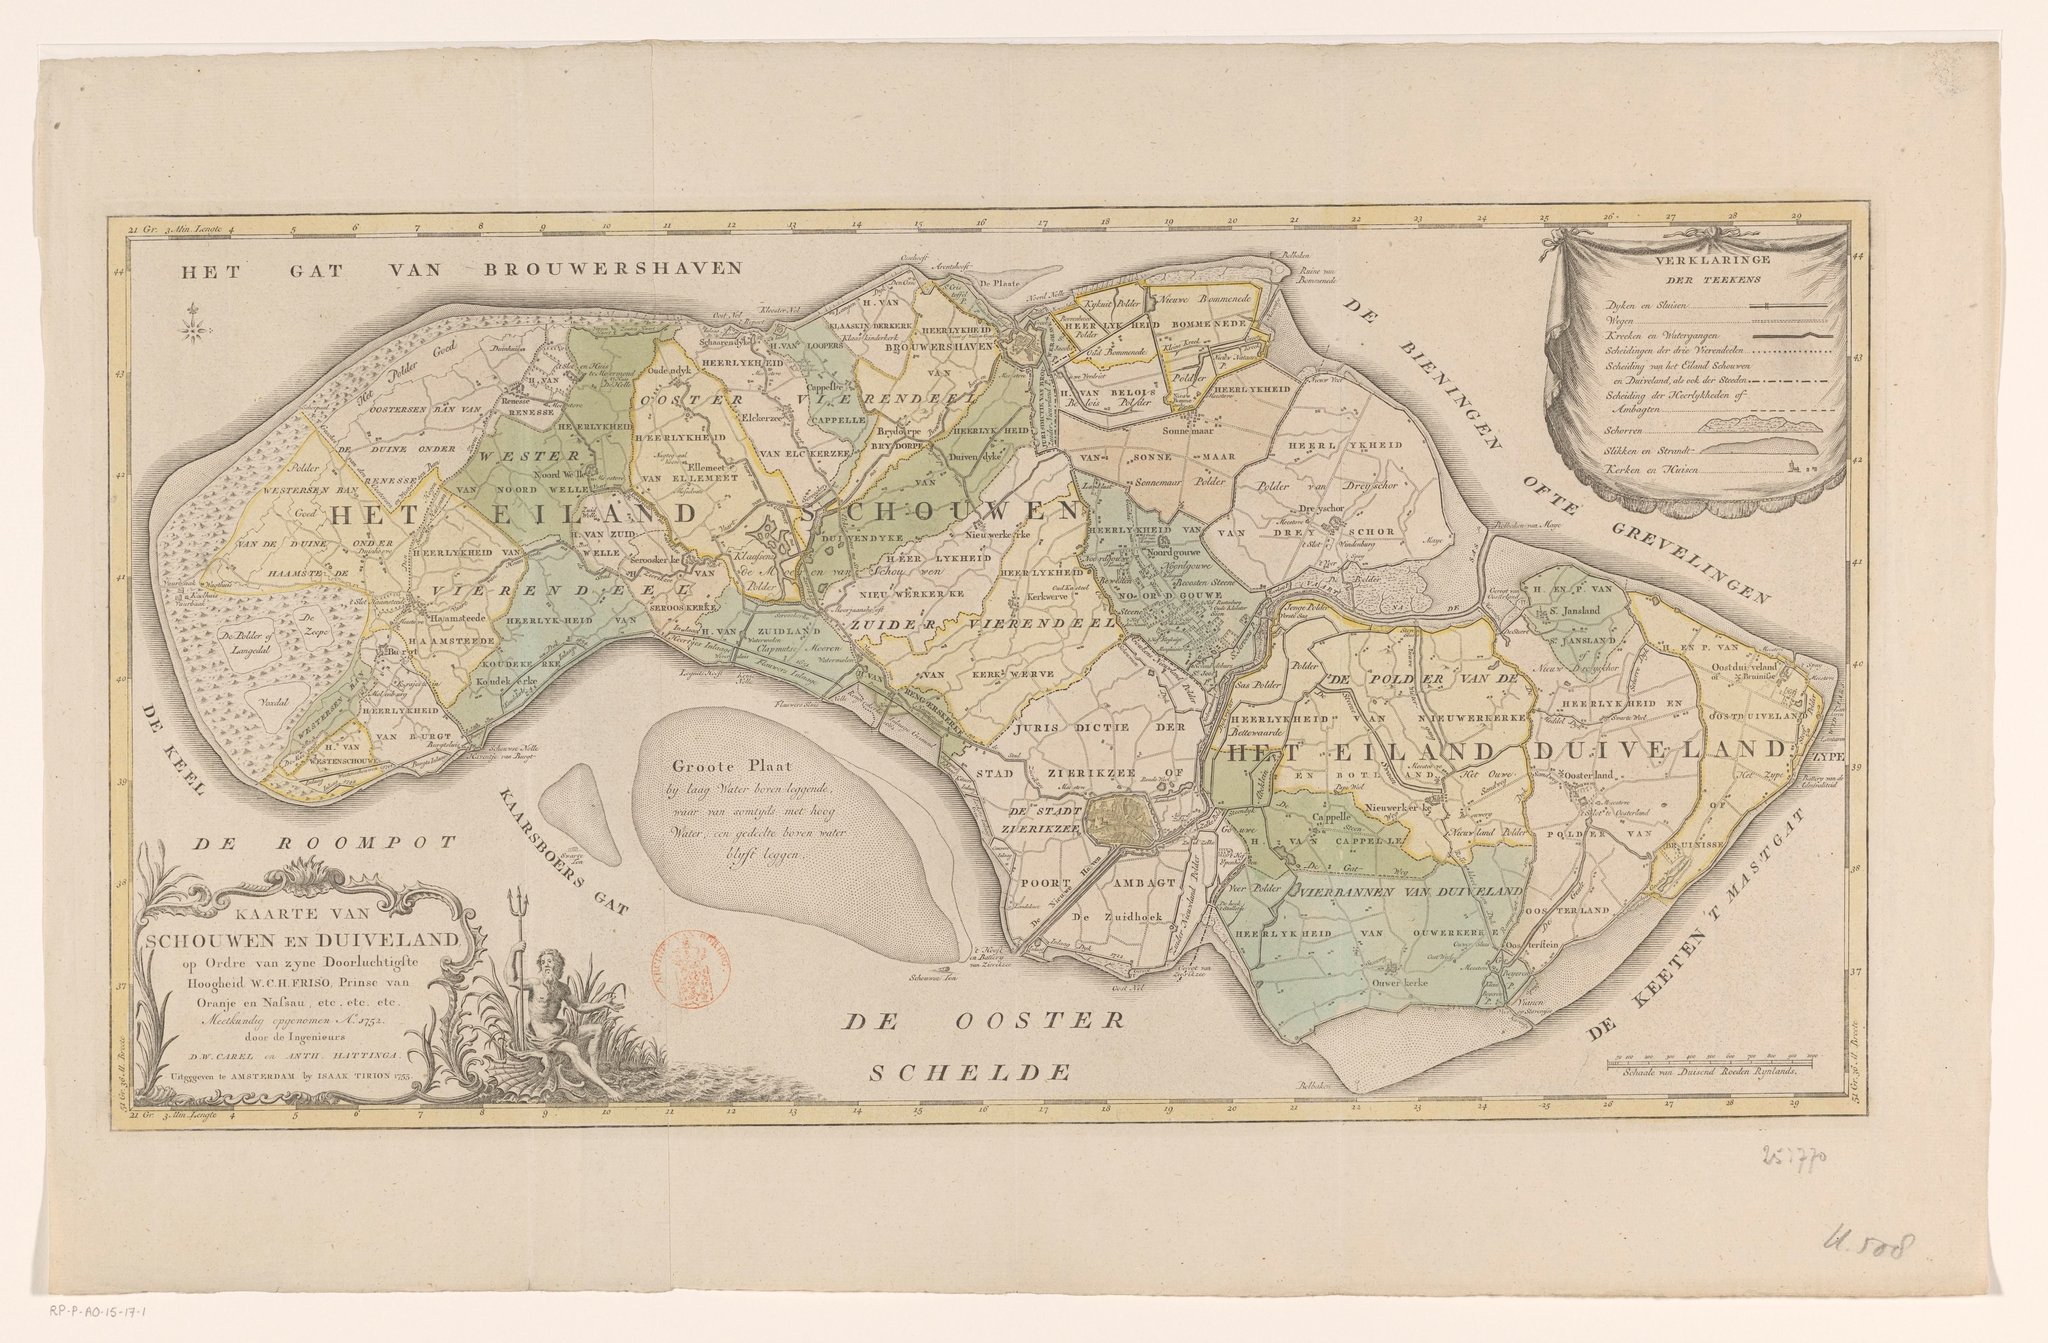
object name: map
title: Kaart van Schouwen-Duiveland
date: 1753-1760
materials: paper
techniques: engraving, etching, hand coloring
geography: amsterdam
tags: (story of) neptune (poseidon), maps of separate countries or regions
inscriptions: collector's mark: Lugt 19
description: Linksonder de titelcartouche met rechts Neptunus. Rechtsboven een cartouche met de legenda. Rechtsonder een schaalstok: Schaale van duisend roeden Rynlands. Gradenverdeling langs de randen.